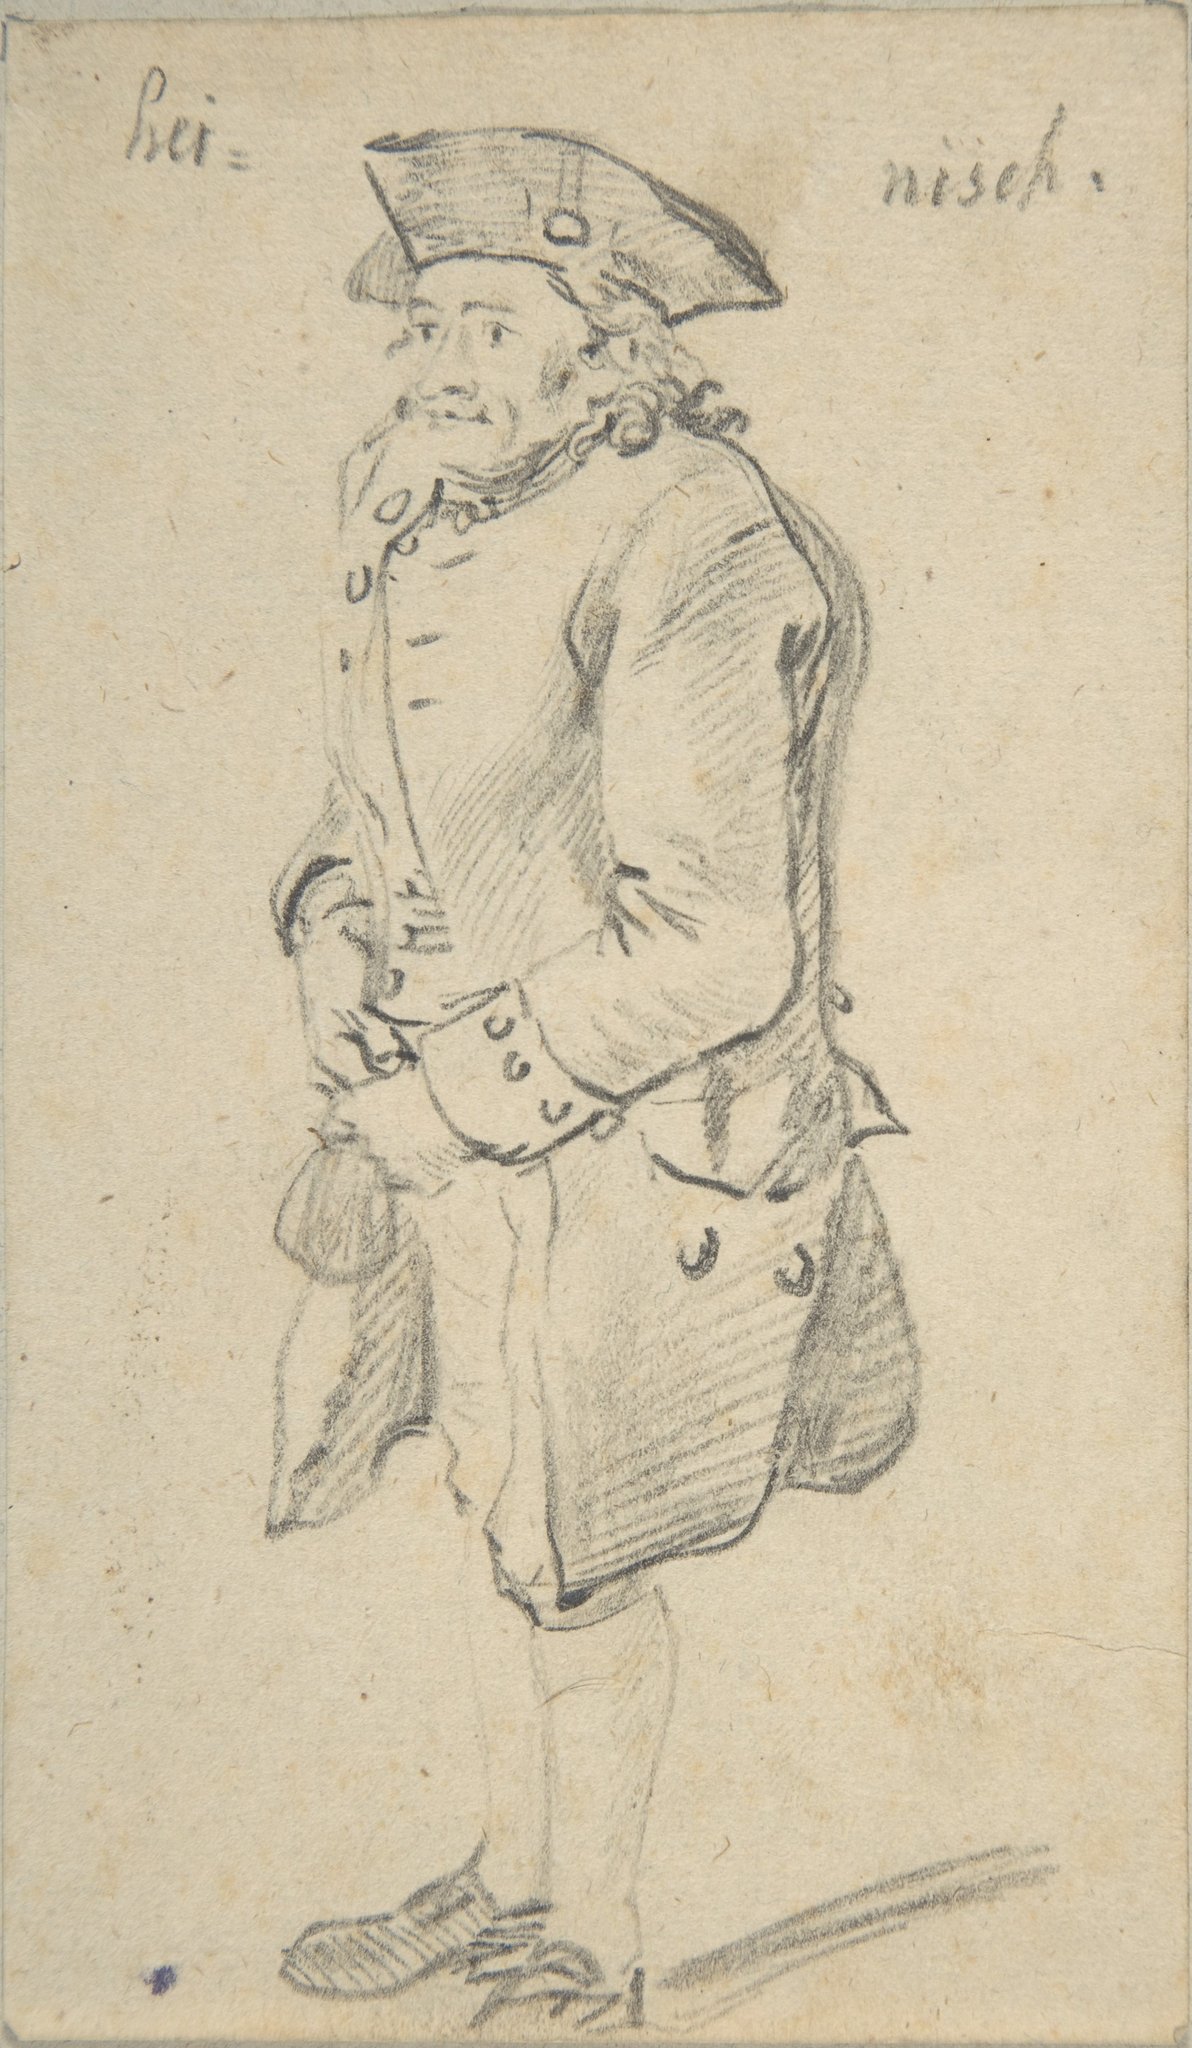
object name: drawing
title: Standing Man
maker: johann christian reinhart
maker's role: artist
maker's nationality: german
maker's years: 1761-1847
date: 1767-1900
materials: chalk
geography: germany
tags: men